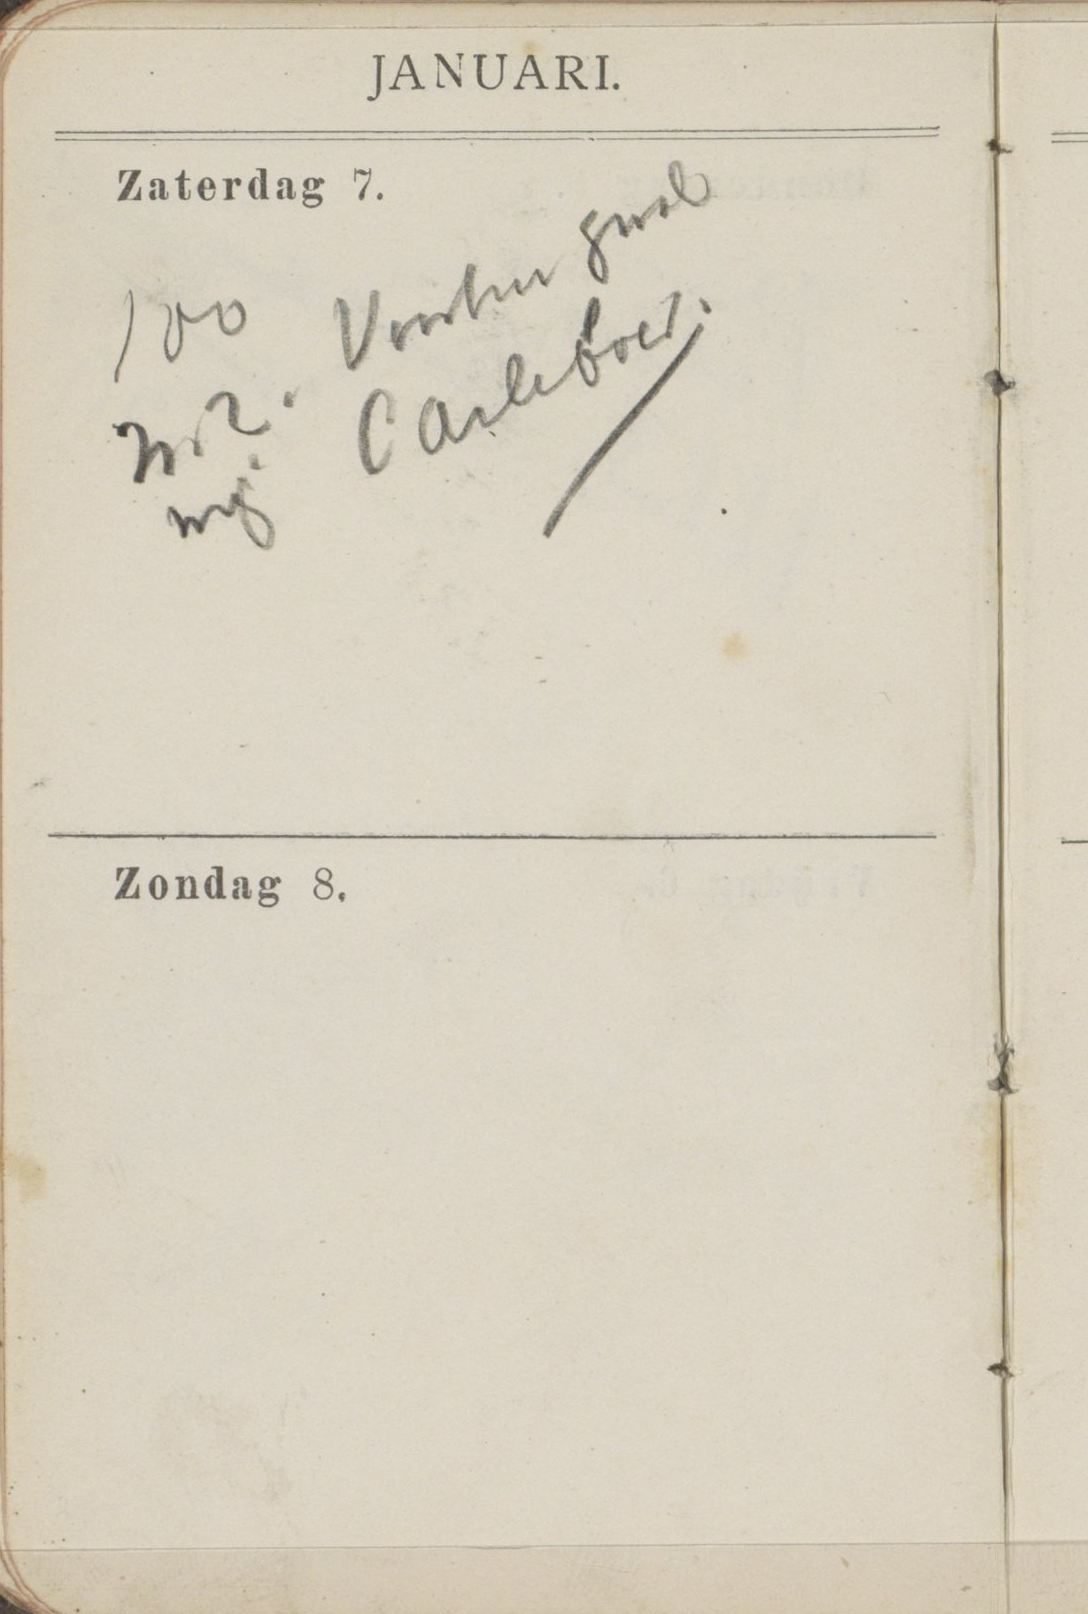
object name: sketchbook leaf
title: Annotaties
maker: george hendrik breitner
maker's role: draughtsman, painter, print maker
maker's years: 1857-1923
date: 1893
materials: chalk, paper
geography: amsterdam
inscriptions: annotation: ‘100/ N.Z. Voorburgwal/ Mgr. Carleboer[?]’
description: Pagina 25 uit een als schetsboek gebruikte agenda met 108 bladen.